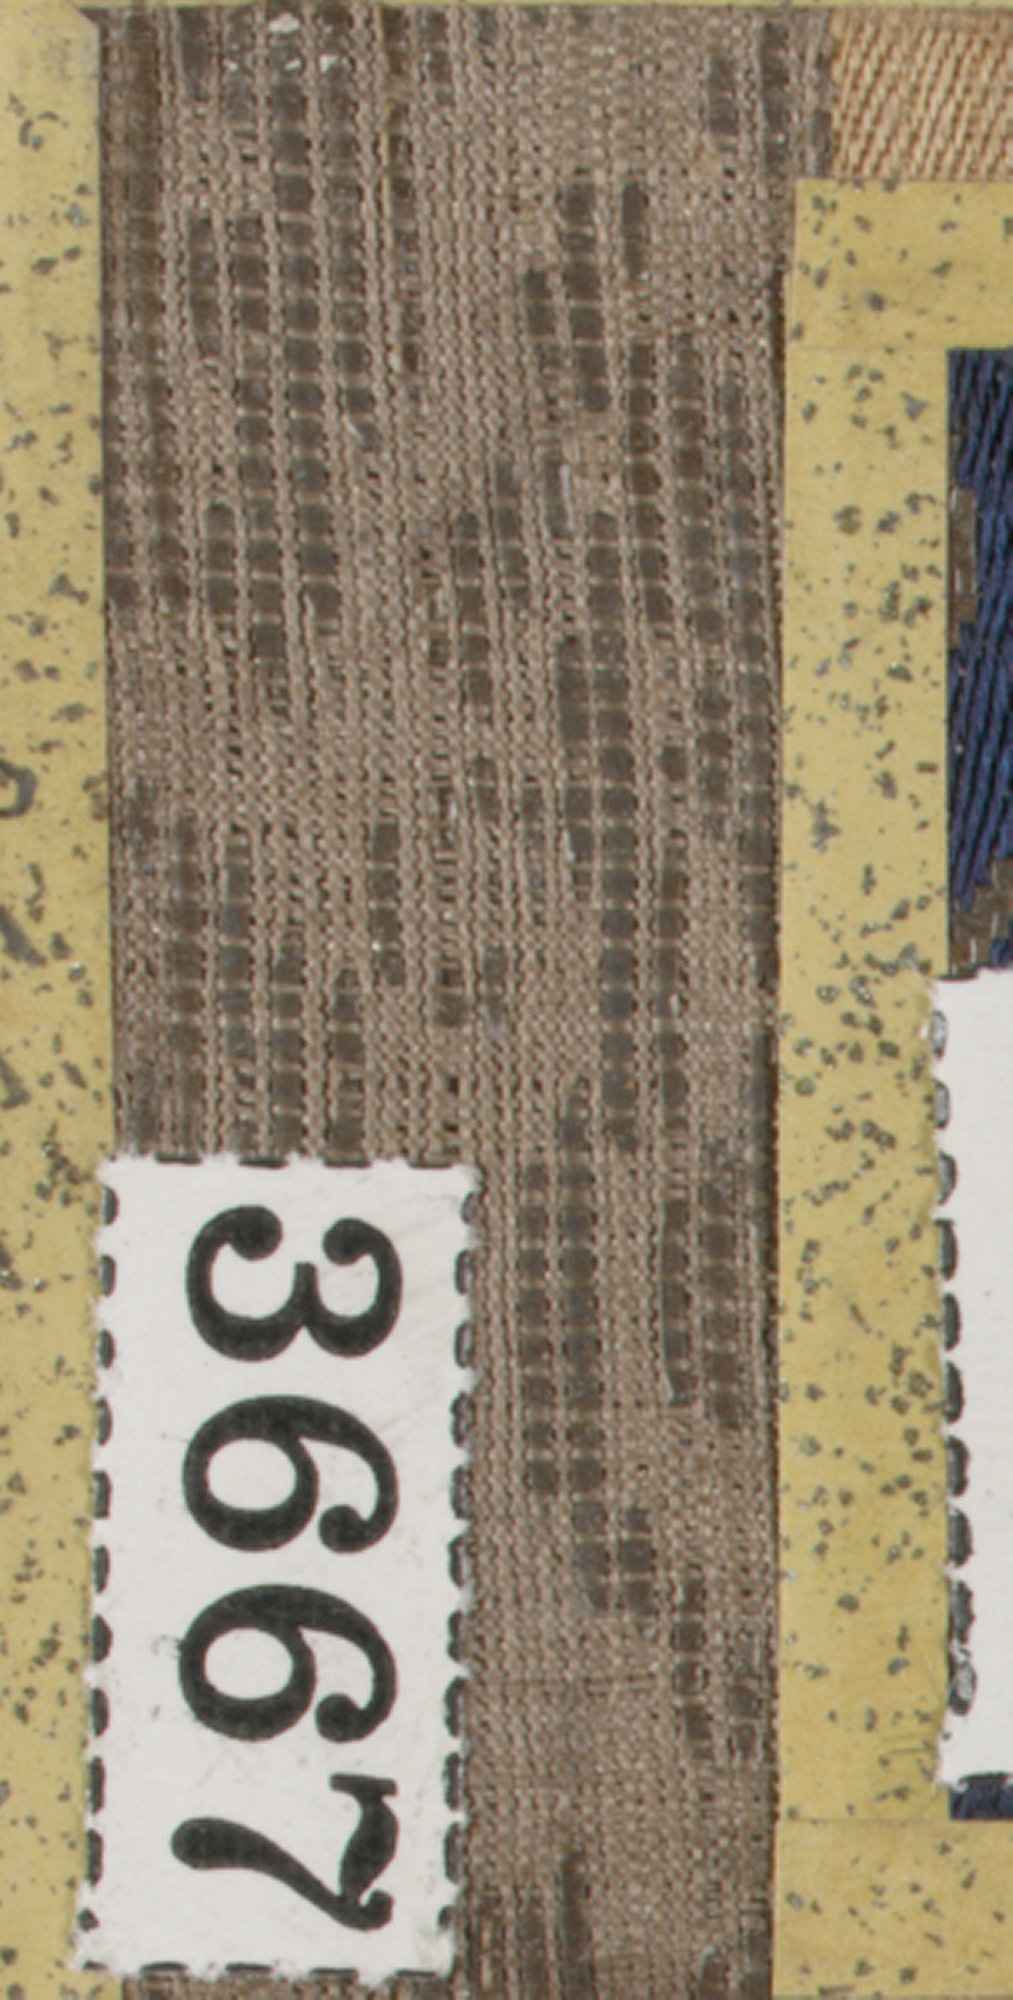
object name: sample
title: Textile Sample from Sample Book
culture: japanese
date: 1801-1900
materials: silk